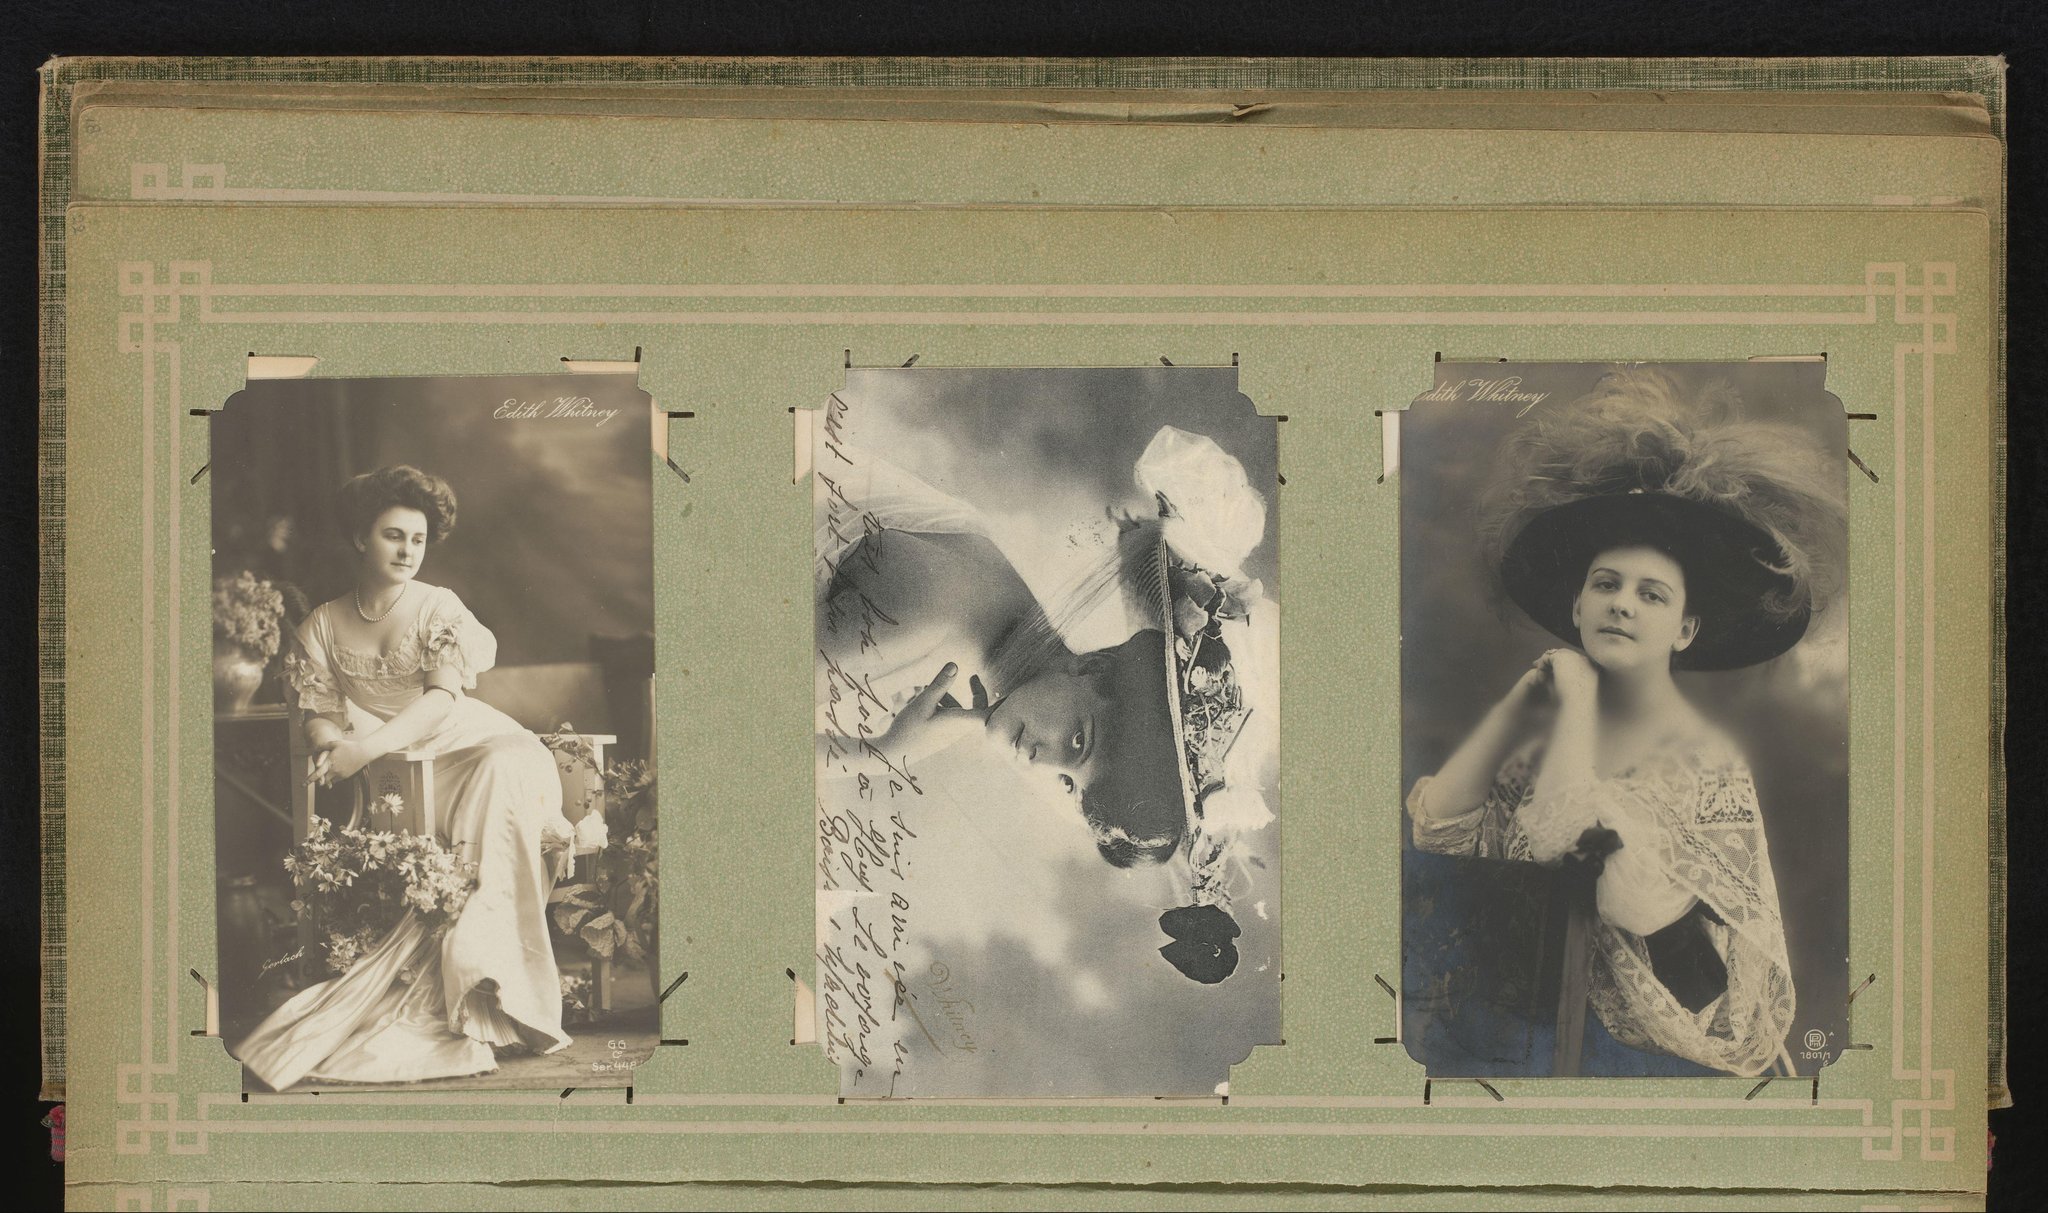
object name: album leaf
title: Drie portretten van Edith Whitney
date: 1900-1930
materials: cardboard, ink, photographic support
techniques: photograph, gelatin silver print, pen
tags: historical persons - bb - woman, portrait of actor, actress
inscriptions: monogram: ‘R/ [P]/ H’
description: Deze foto's en prent maken deel uit van een album.